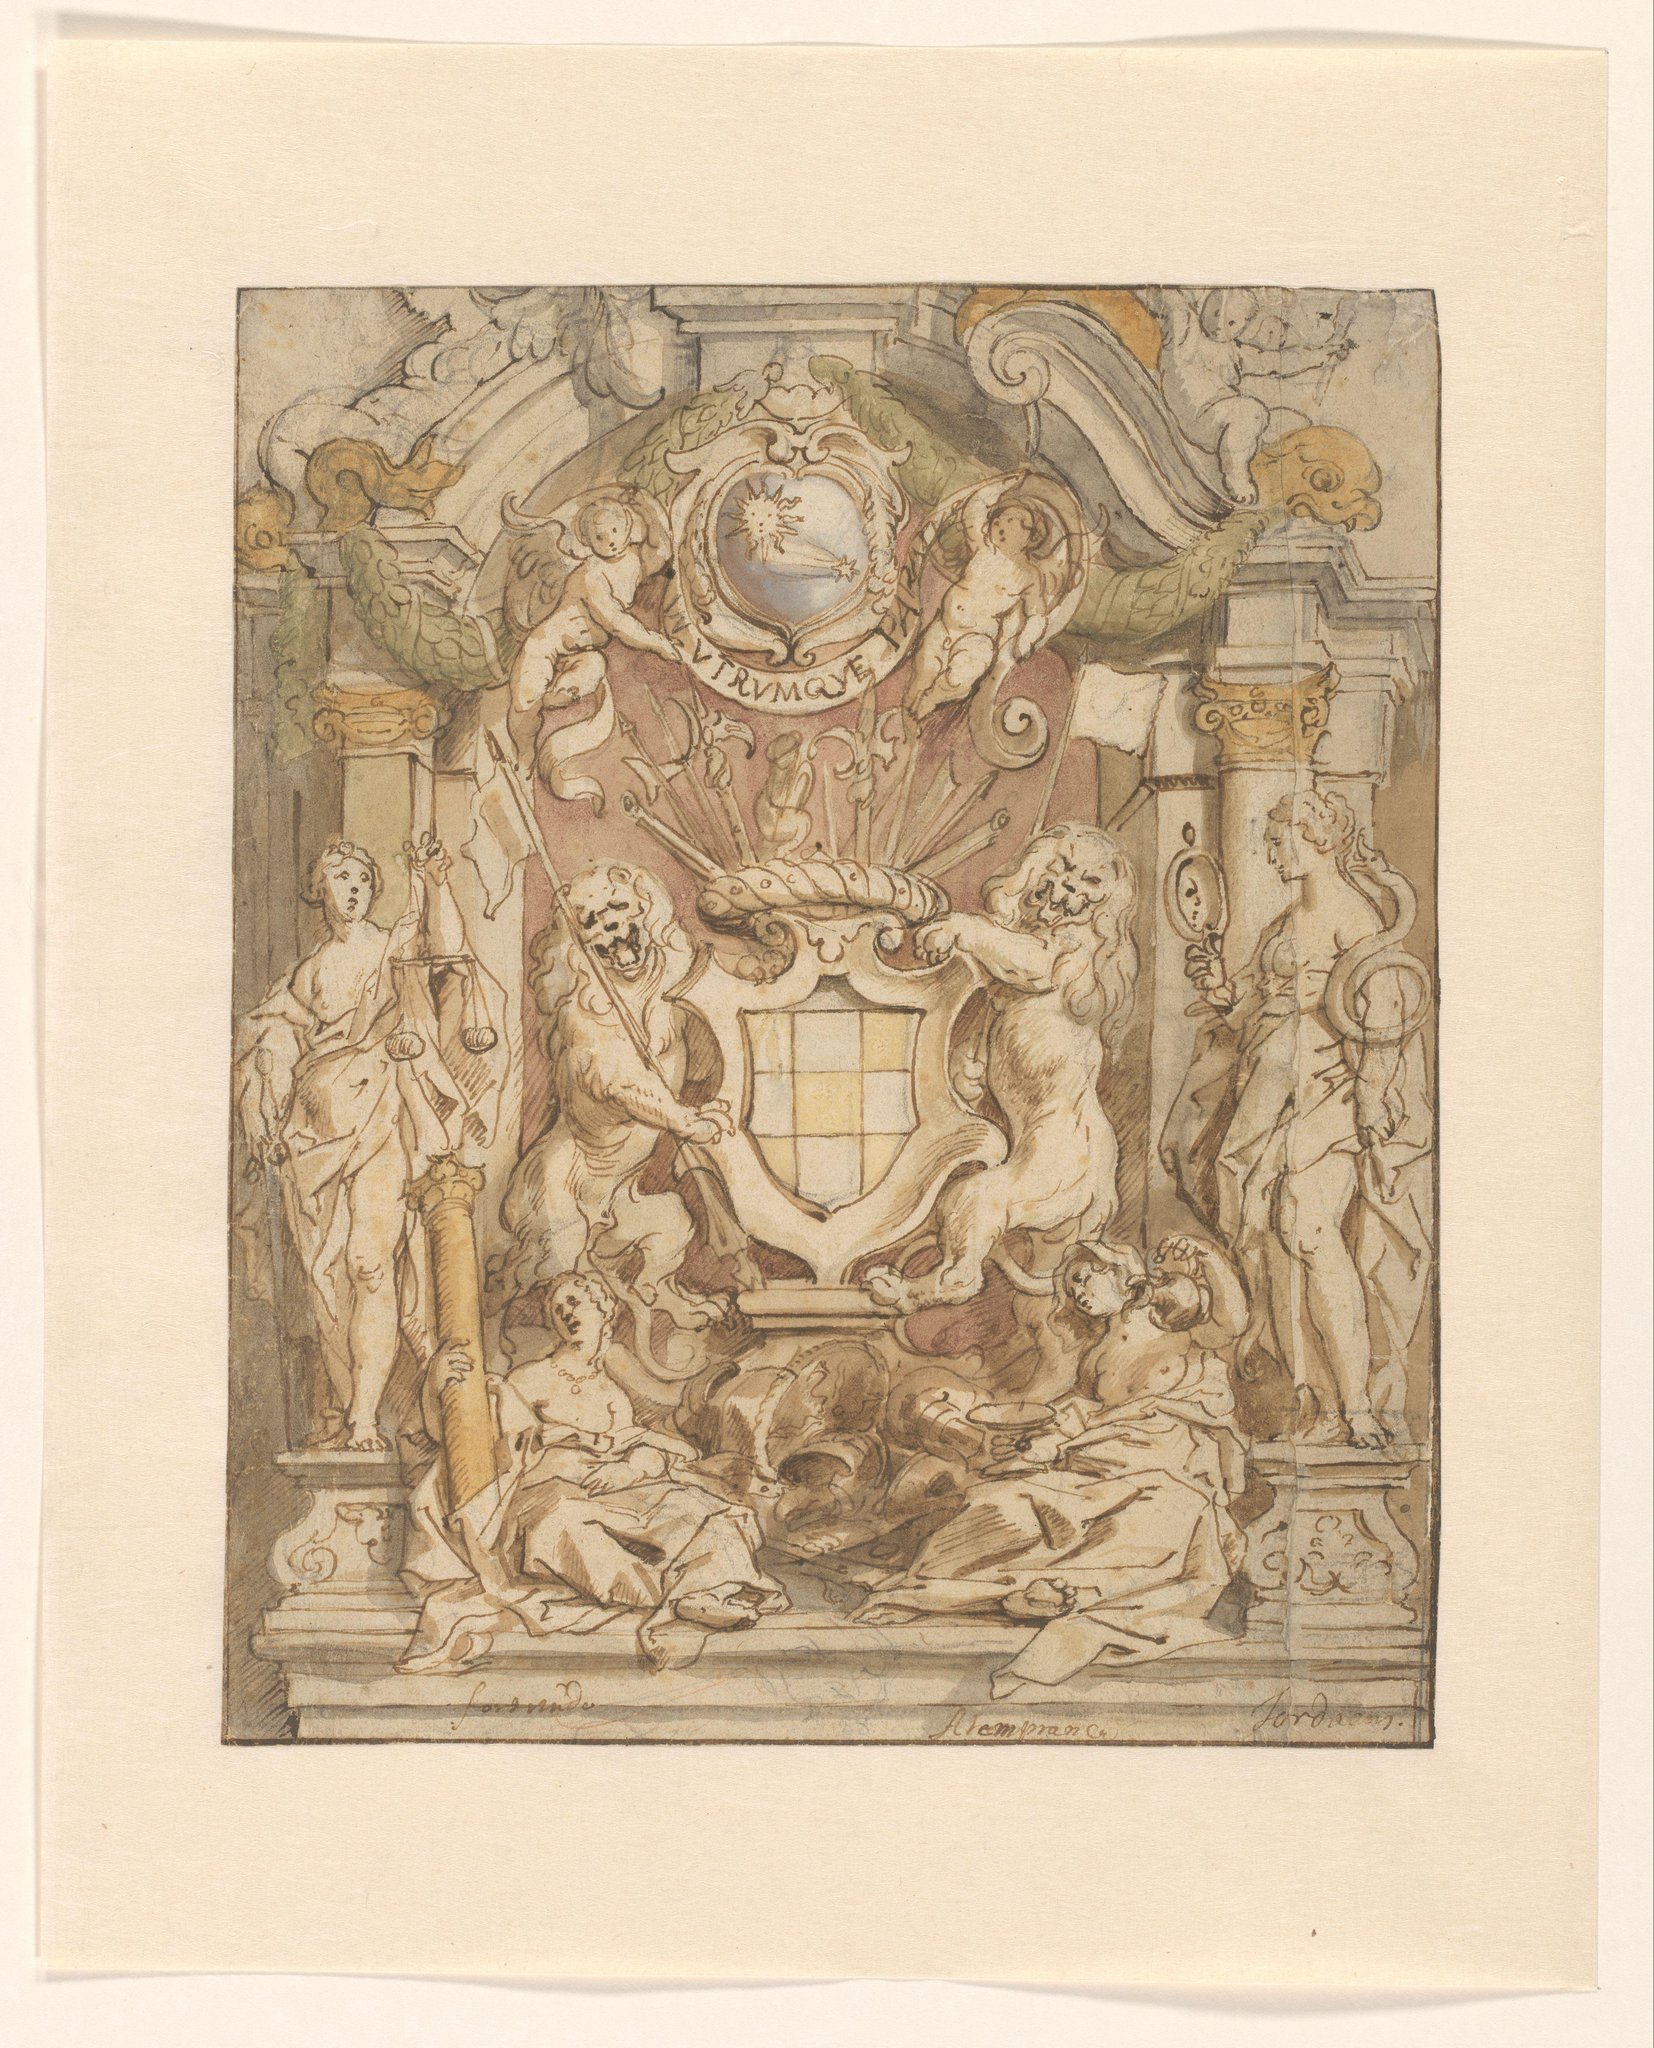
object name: drawing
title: Het wapen van Van der Linden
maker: jacques jordaens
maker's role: designer, draughtsman, painter, print maker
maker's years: 1593-1678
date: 1630-1635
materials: chalk, ink, paper, watercolor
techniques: brush, pen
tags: fortitude, 'fortitudo' ~ one of the four cardinal virtues, temperance, 'temperantia'; 'temperanza' (ripa) ~ one of the four cardinal virtues, justice, 'justitia'; 'giustitia divina' (ripa) ~ one of the four cardinal virtues, prudence, 'prudentia'; 'prudenza' (ripa) ~ one of the four cardinal virtues, armorial bearing, heraldry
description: Modello met een wapenschild en allegorische figuren.